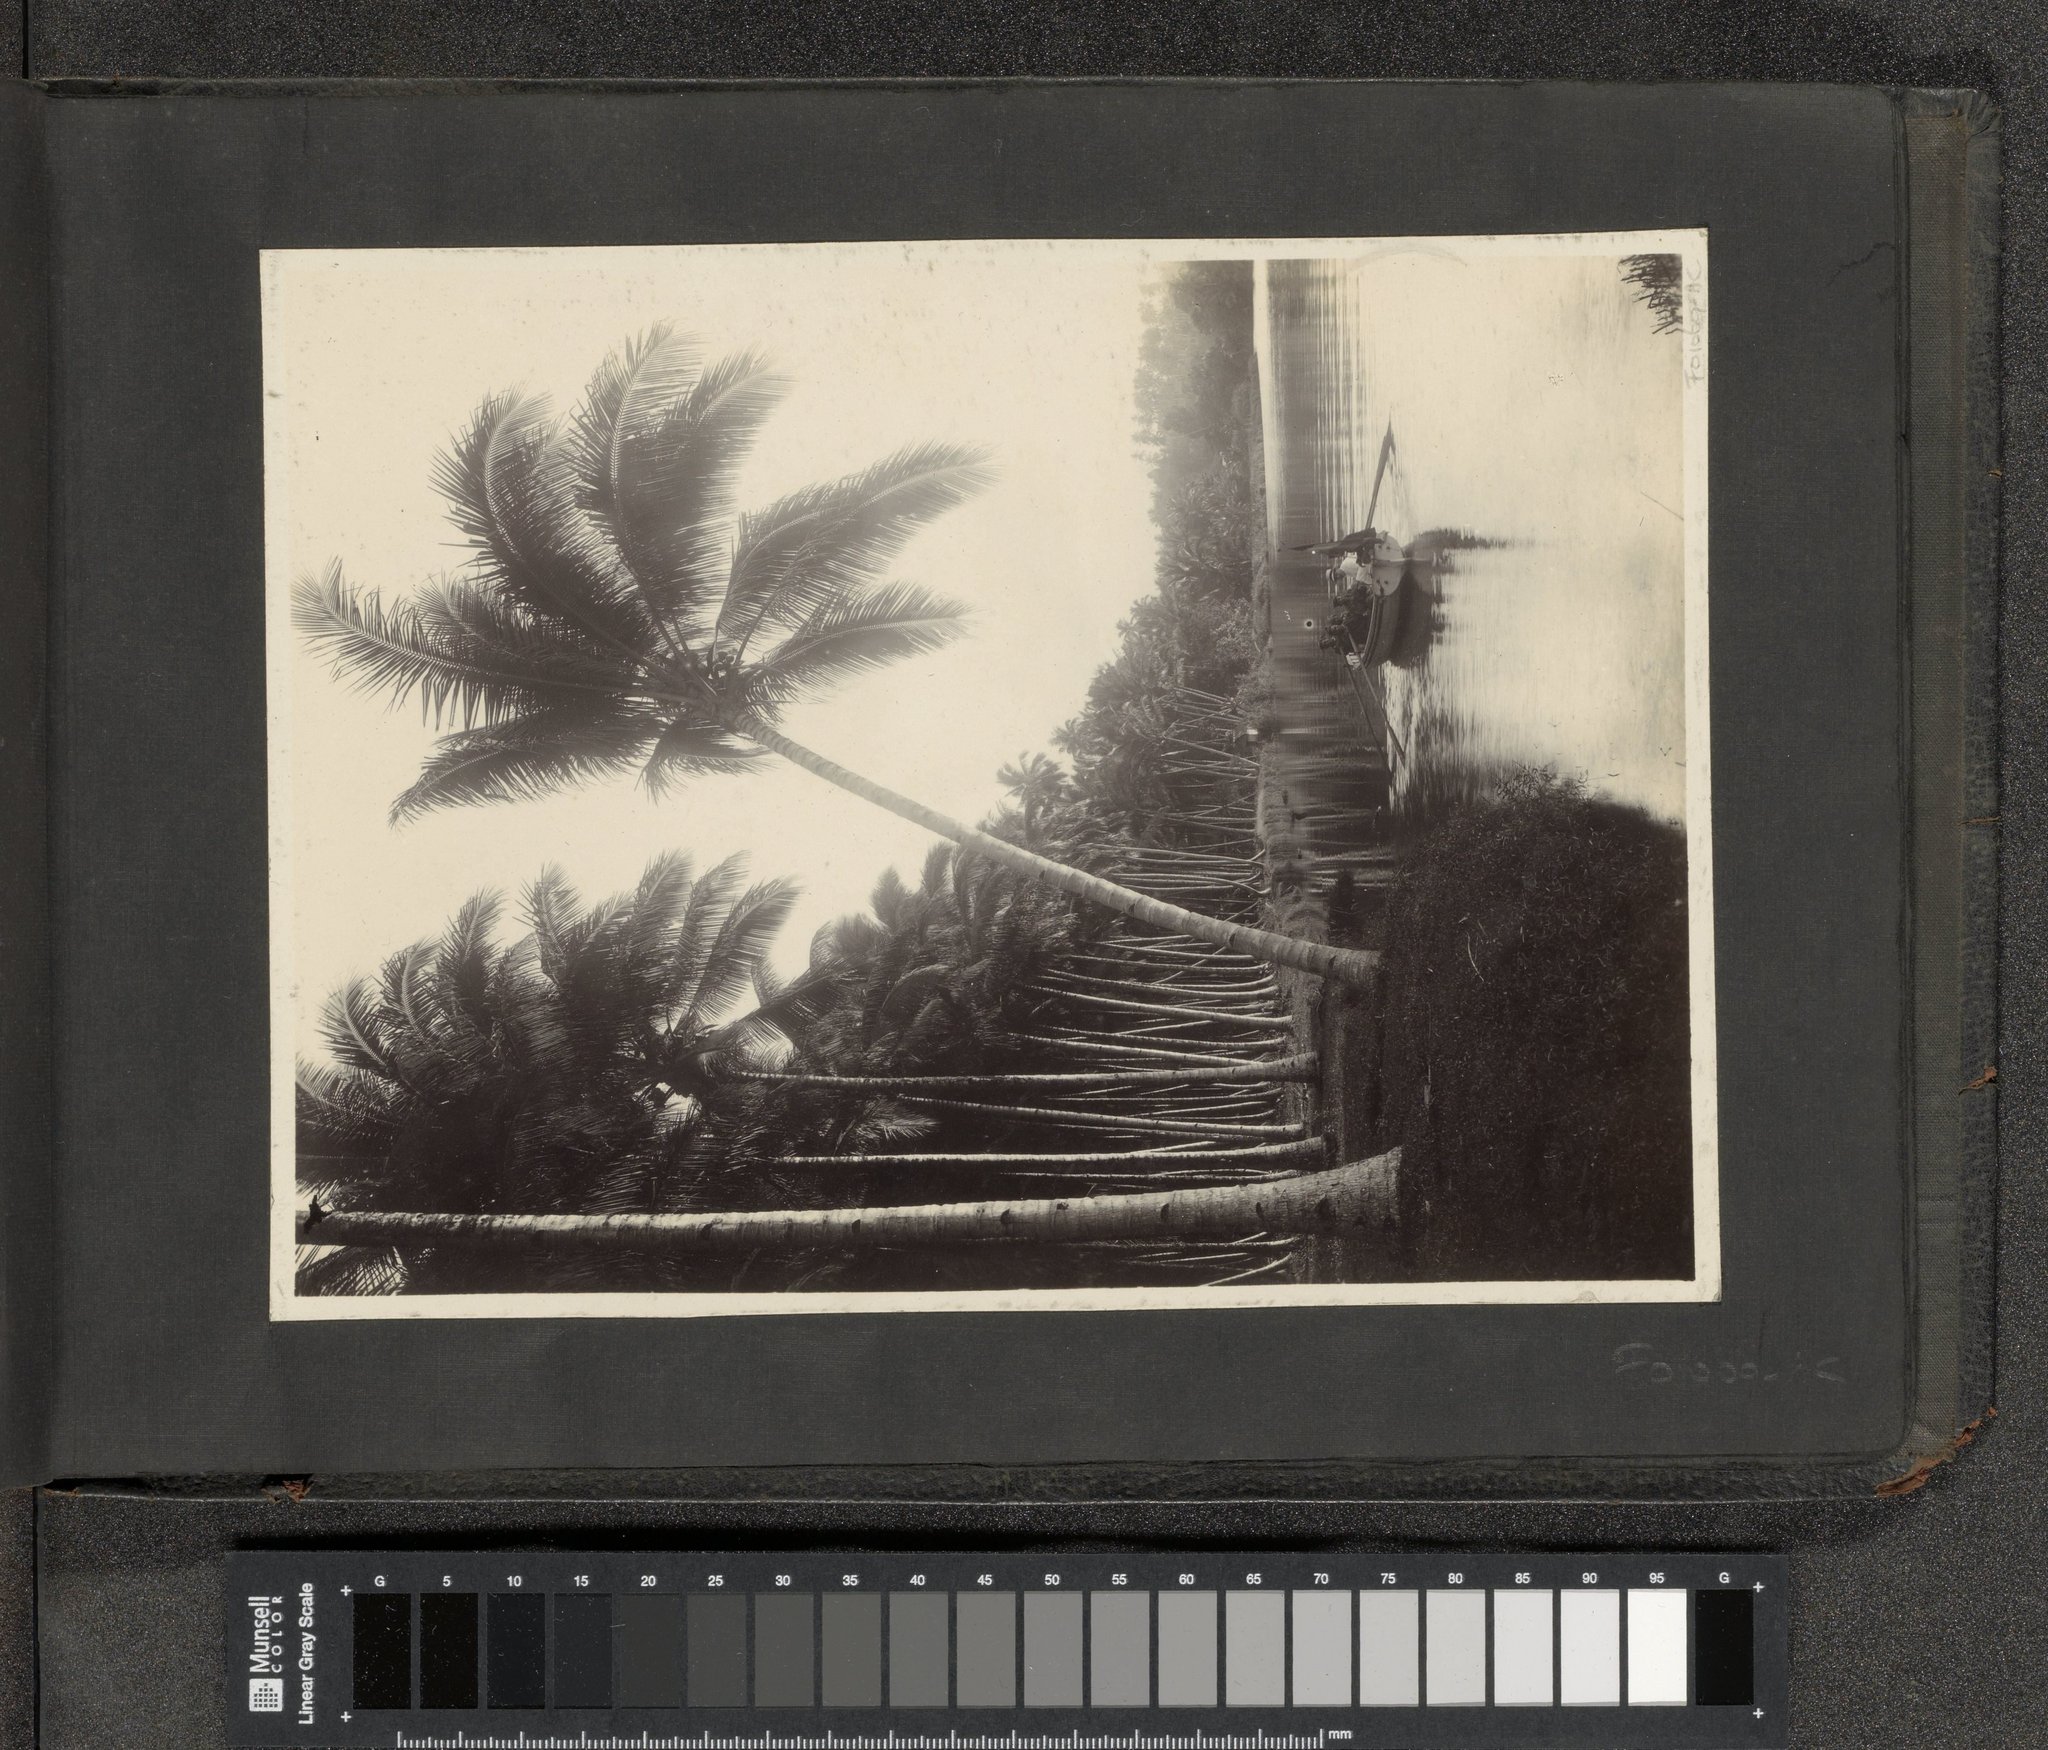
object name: photograph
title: Boot bij een palmenkust in Nederlands-Indië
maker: onnes kurkdjian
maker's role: fotograaf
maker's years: 1851-1903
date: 1912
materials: paper, photographic support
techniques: gelatin silver print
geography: dutch east indies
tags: trees: palm-tree, beach, dutch east indies, the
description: Onderdeel van Reisalbum met veertig foto's van Nederlands-Indië.